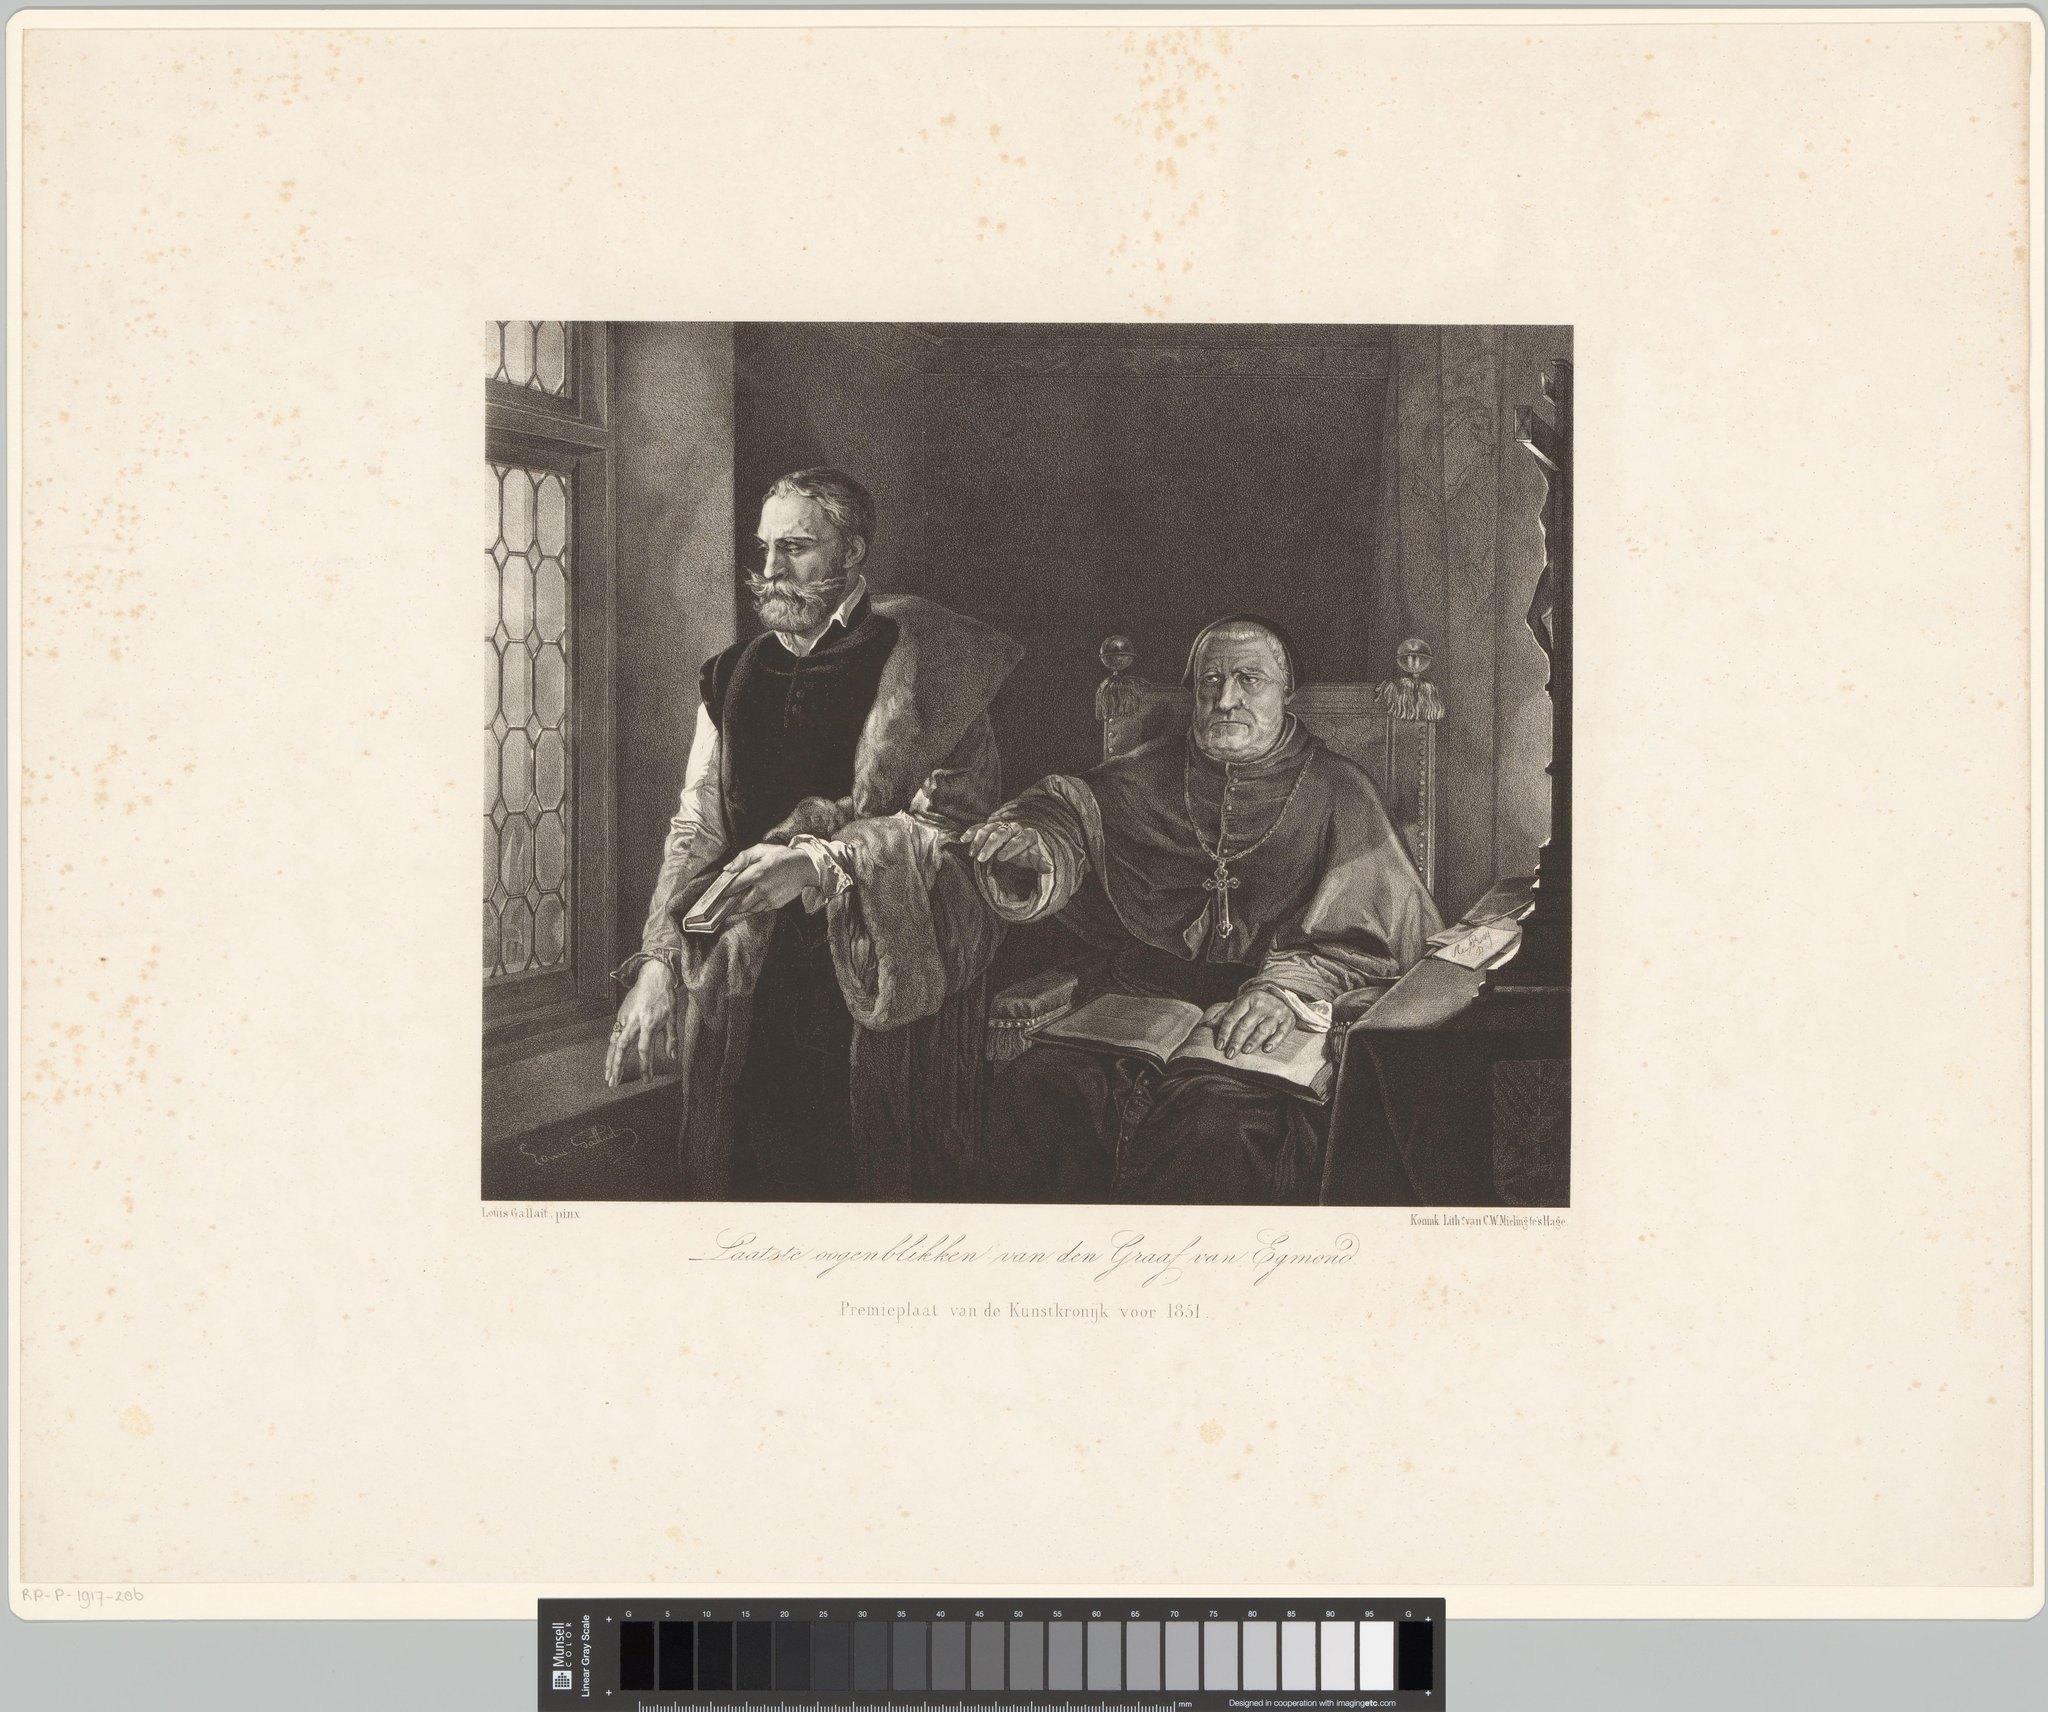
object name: print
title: Laatste ogenblikken van Lamoraal van Egmond in zijn cel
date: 1851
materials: paper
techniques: lithograph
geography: the hague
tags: brussels, earl, spiritual support (during last hours before execution)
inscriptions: collector's mark: Lugt 2228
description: De laatste ogenblikken van de graaf van Egmond vóór zijn terechtstelling op 5 juni 1568. Egmond staand bij een venster, achter hem zit een priester bij een tafel met kruisbeeld. Premieplaat bij Kunstkronijk 1851.